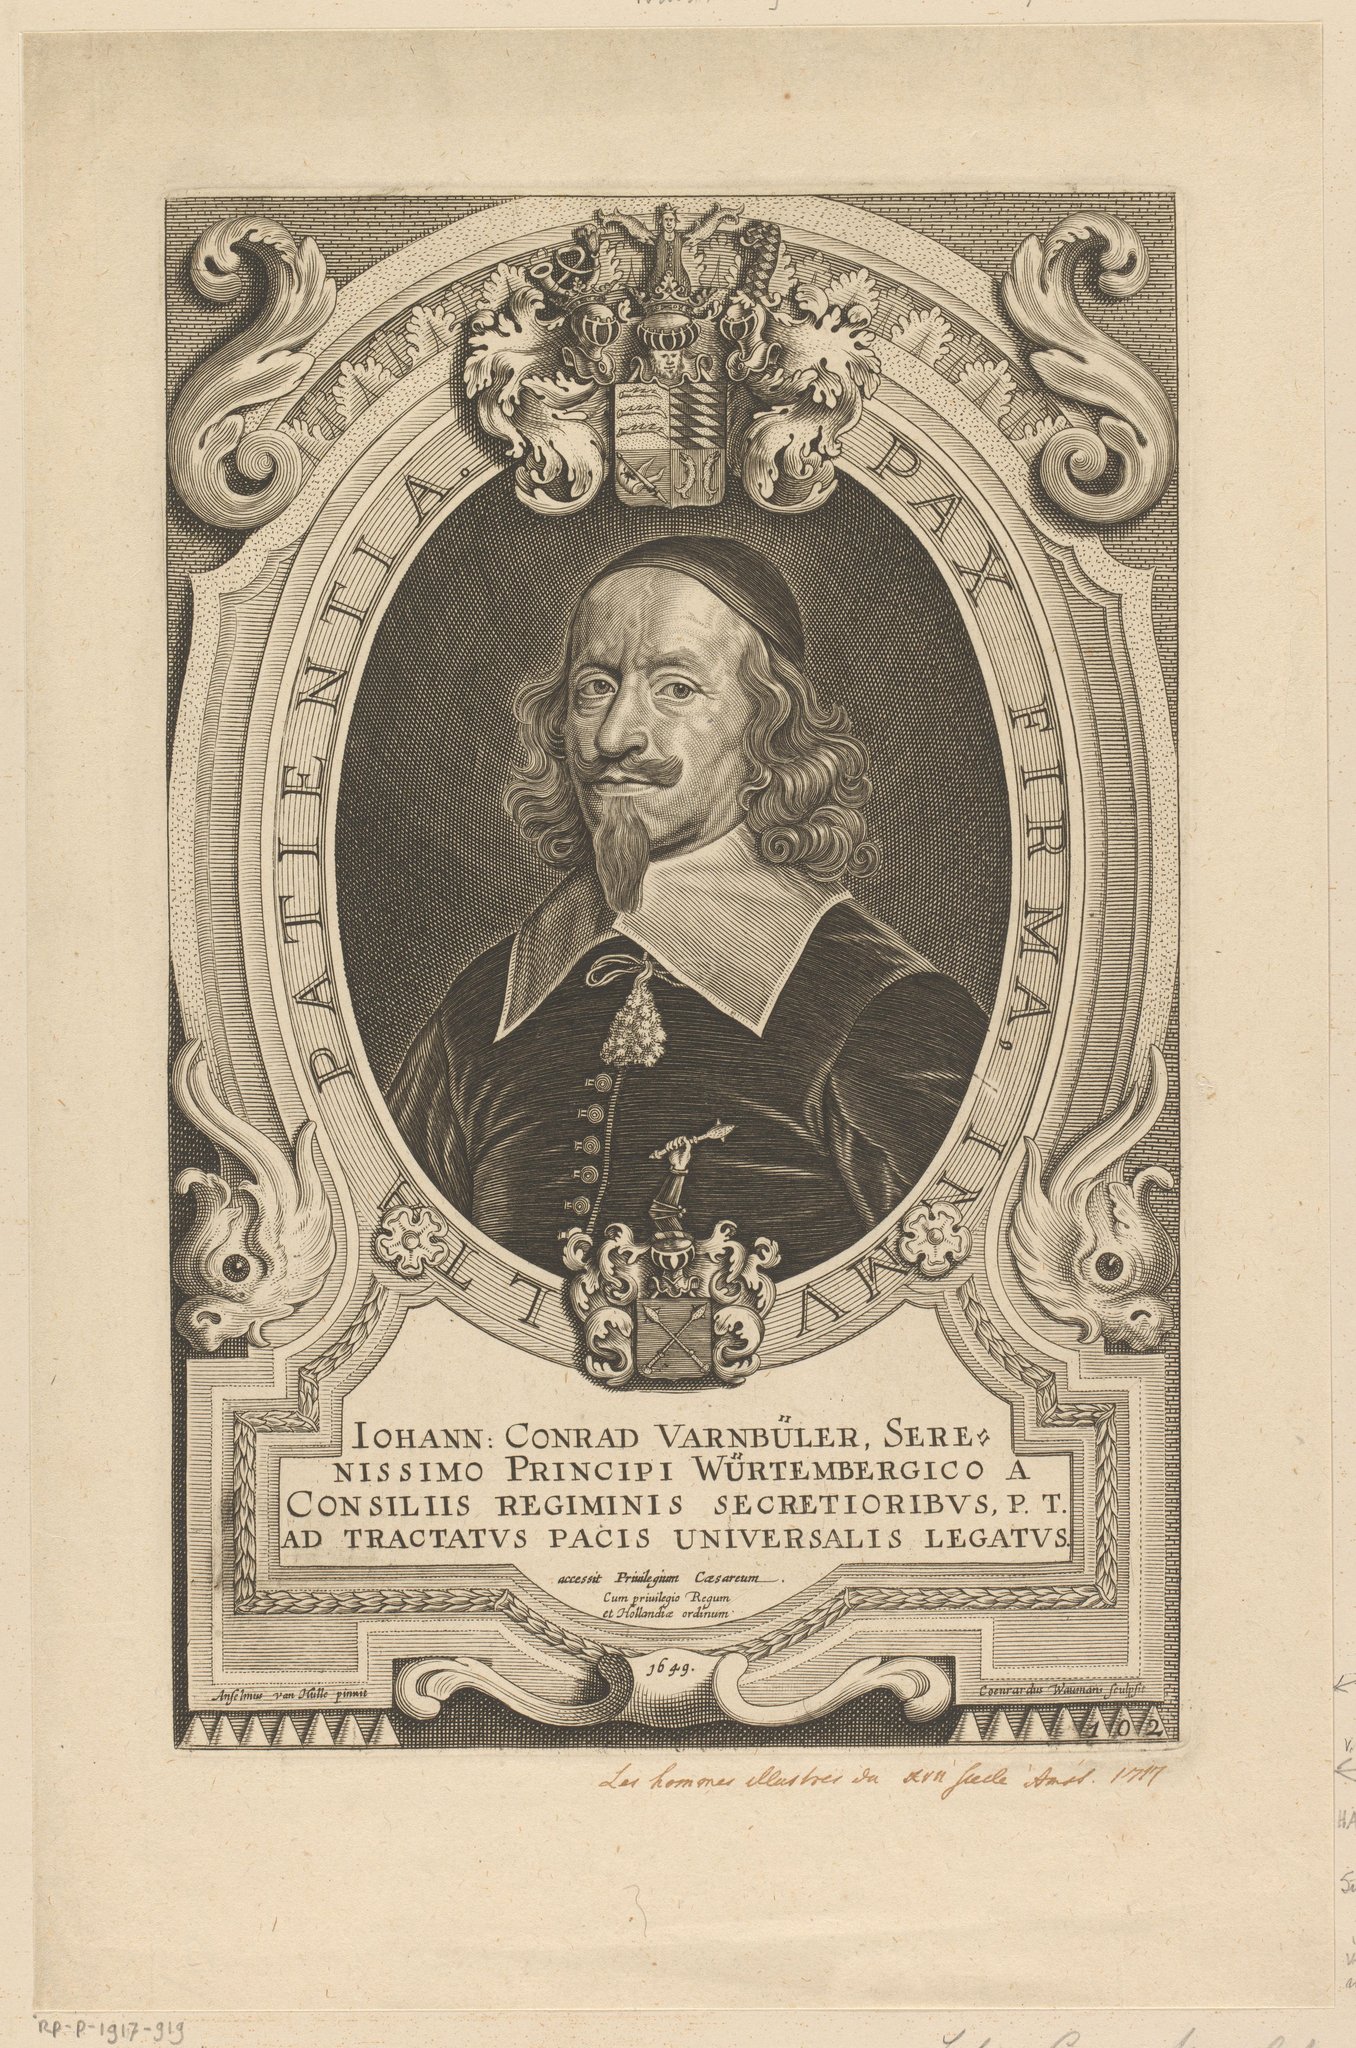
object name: print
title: Iohann: Conrad Varnbüler, serenissimo principi Würtembergico a consiliis (...)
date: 1713-1717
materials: paper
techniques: engraving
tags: politician, official; civil servant; functionary (in general), historical persons, lawyer, attorney at law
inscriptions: inscription: ‘Les hommes illustres la XVII siecle Amst. 1717’, collector's mark: Lugt 2228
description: Prent is gebruikt in verschillende series. De huidige staat is gebruikt in de hieronder vermelde serie en uitgaven (6) en (7). (1)‘Legati Celeberrimi’, uitgegeven door Daniel Middeler in 1648 in Antwerpen. (2)‘Legati Celeberrimi’, waarschijnlijk uitgegeven in 1651, maar opnieuw met de vermelding door Daniel Middeler in 1648 in Antwerpen. (3)‘Legati Celeberrimi', waarschijnlijk uitgegeven in 1658, maar opnieuw met de vermelding door Daniel Middeler in 1648 in Antwerpen. (4) 'Pacificatores orbis Christiani, sive icones principum, ducum et legatorum, qui Monasterii atque Osnabrugae (...)', uitgegeven door Pieter van der Slaart in 1696 in Rotterdam. (5) 'Pacificatores orbis Christiani, sive icones principum, ducum et legatorum, qui Monasterii atque Osnabrugae (...)', uitgegeven door Pieter van der Slaart in 1697 in Rotterdam. (6) 'Pacificatores orbis Christiani, sive icones principum, ducum et legatorum, qui Monasterii atque Osnabrugae (...)', waarschijnlijk uitgegeven circa 1713, maar opnieuw met vermelding van Pieter van der Slaart in 1697 in Rotterdam. De platen in deze uitgave zijn voor het eerst genummerd. (7) 'Les hommes illustres qui ont vécu dans le XXIIe siècle (...)', uitgegeven door David Mortier in 1717 in Rotterdam. Zie documentatie. Mogelijk zijn er nog meerdere uitgaven en staten van deze prent.